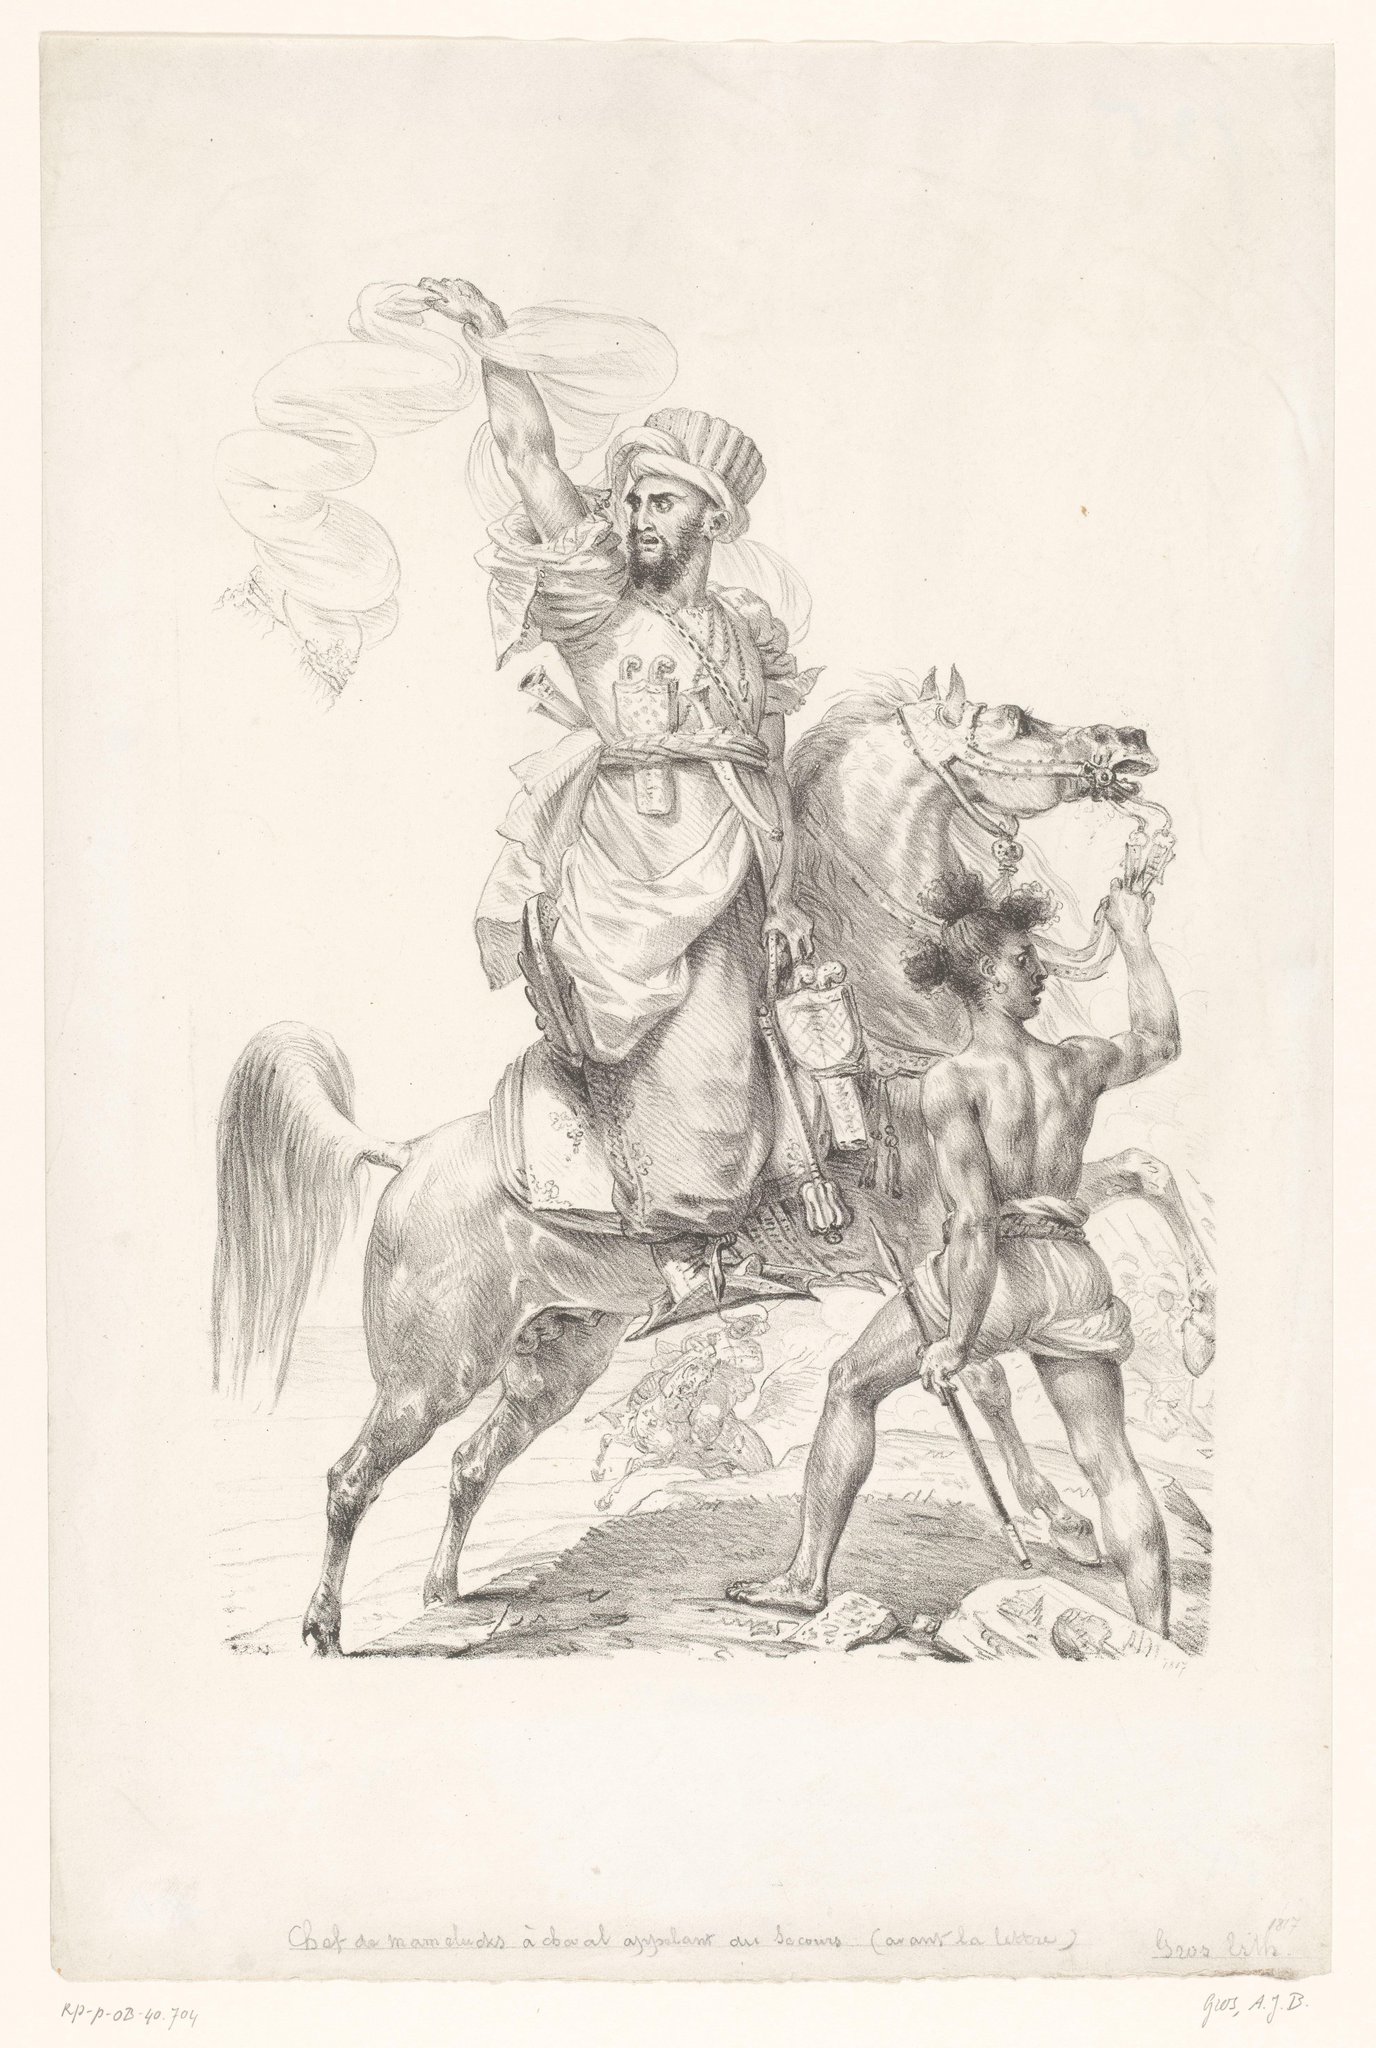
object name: print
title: Aanvoerder van de Mammelukken roept te paard om hulp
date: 1817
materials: paper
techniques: lithography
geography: paris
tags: riding a horse, ass, or mule; rider, horseman, slavery; serfs and enslaved persons, (military) attack